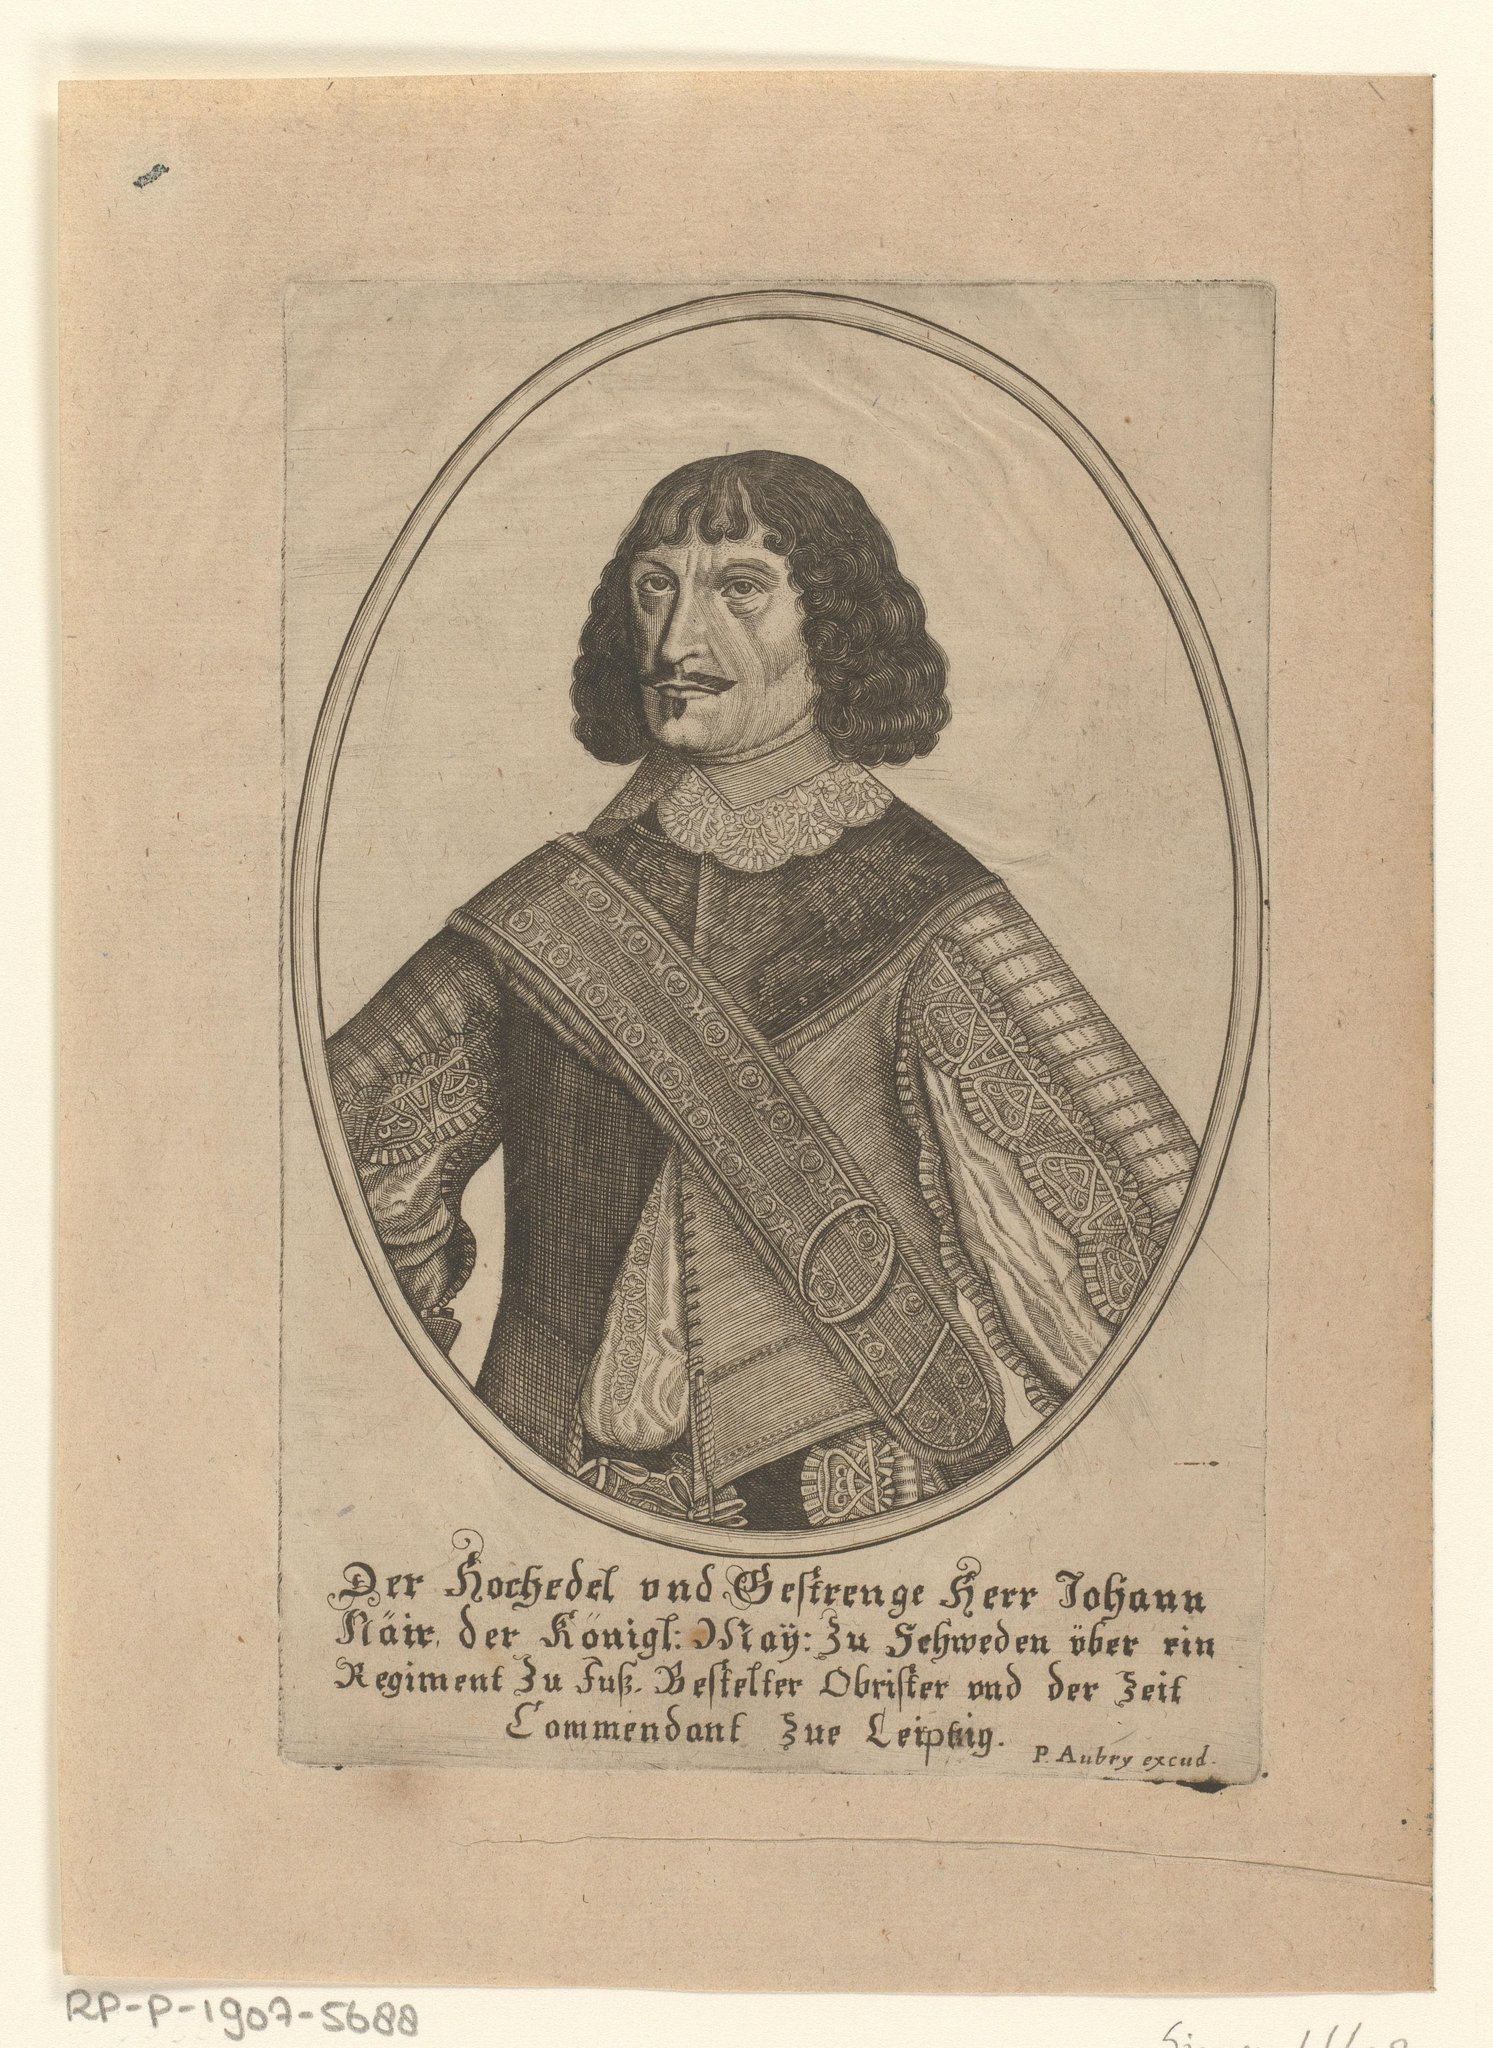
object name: print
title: Portret van Johann Nair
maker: Anonymous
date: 1606-1686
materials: paper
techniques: engraving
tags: historical persons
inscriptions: collector's mark: Lugt 2228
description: Met vierregelig onderschrift in het Duits.